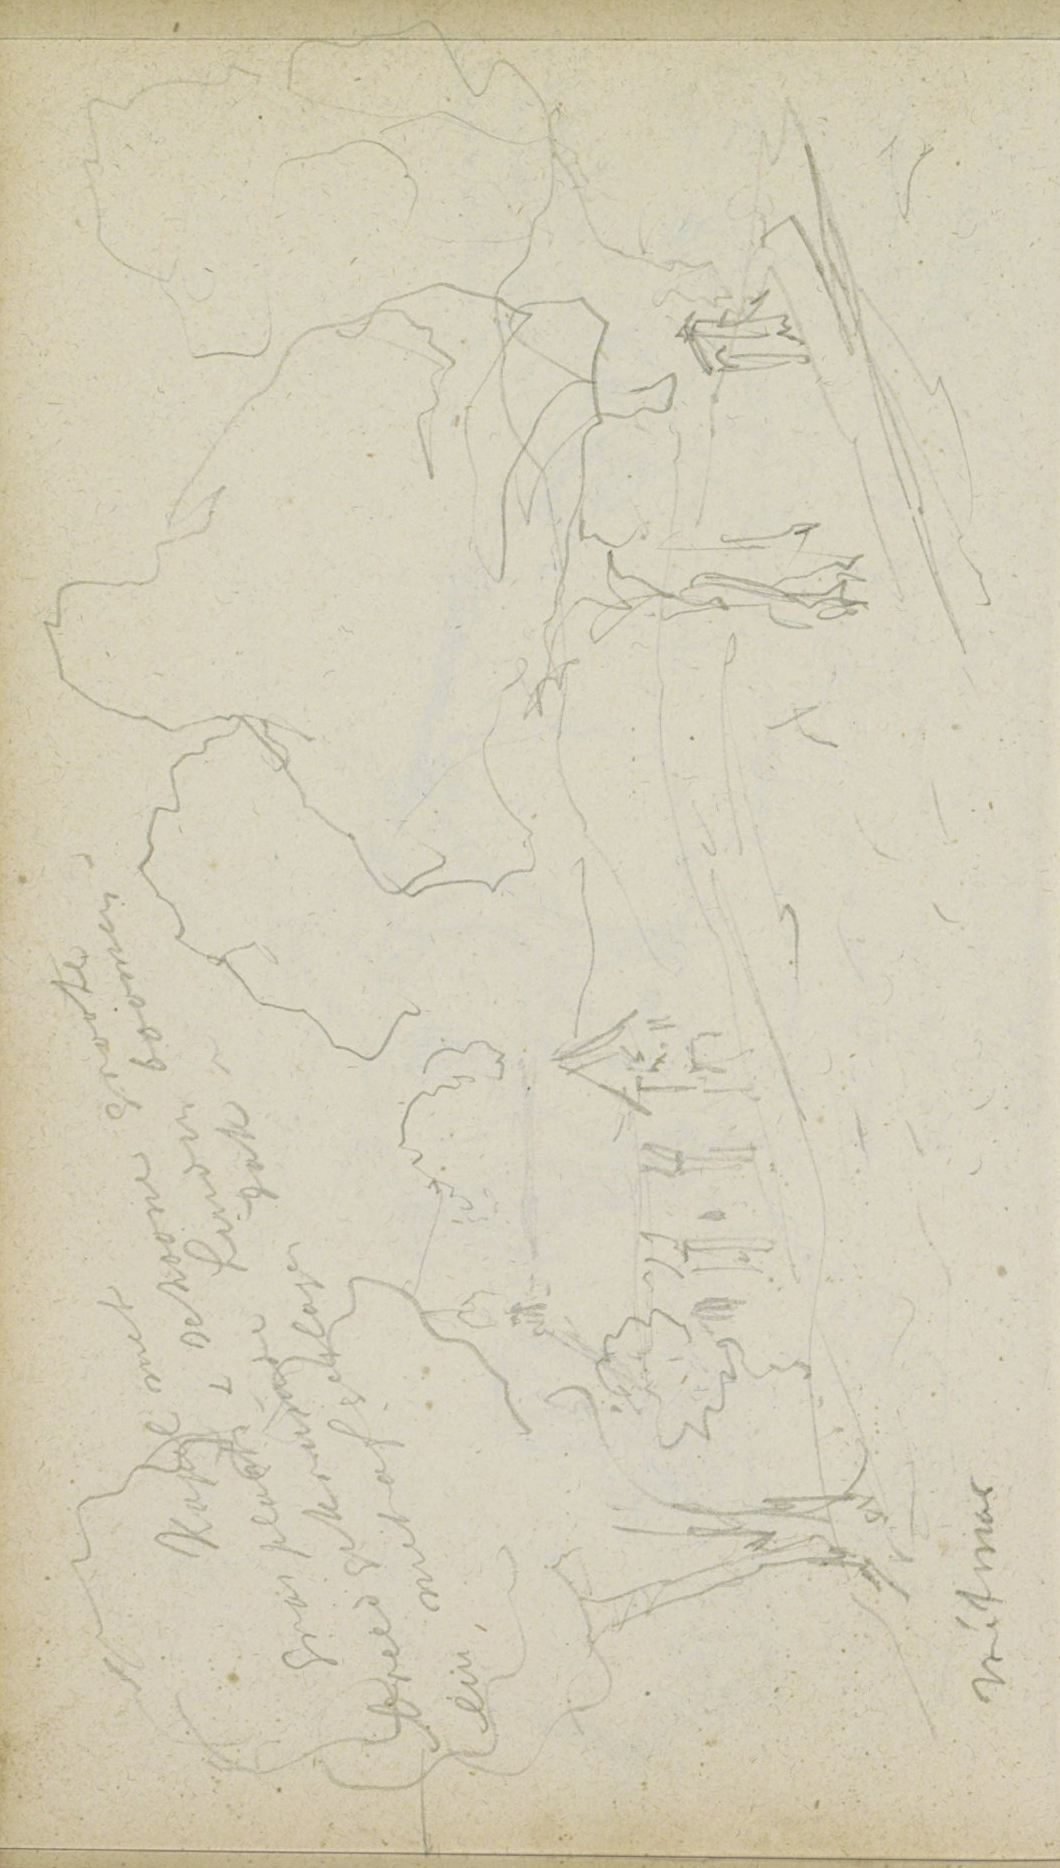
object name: sketchbook leaf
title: Kapel tussen de bomen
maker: johannes tavenraat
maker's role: draughtsman, painter, print maker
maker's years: 1809-1881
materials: paper, pencil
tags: parts of church exterior and annexes: chapel - qq - small church, chapel, trees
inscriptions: kleurnotitie, handgeschreven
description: Blad 19 verso uit een schetsboek met 88 bladen.